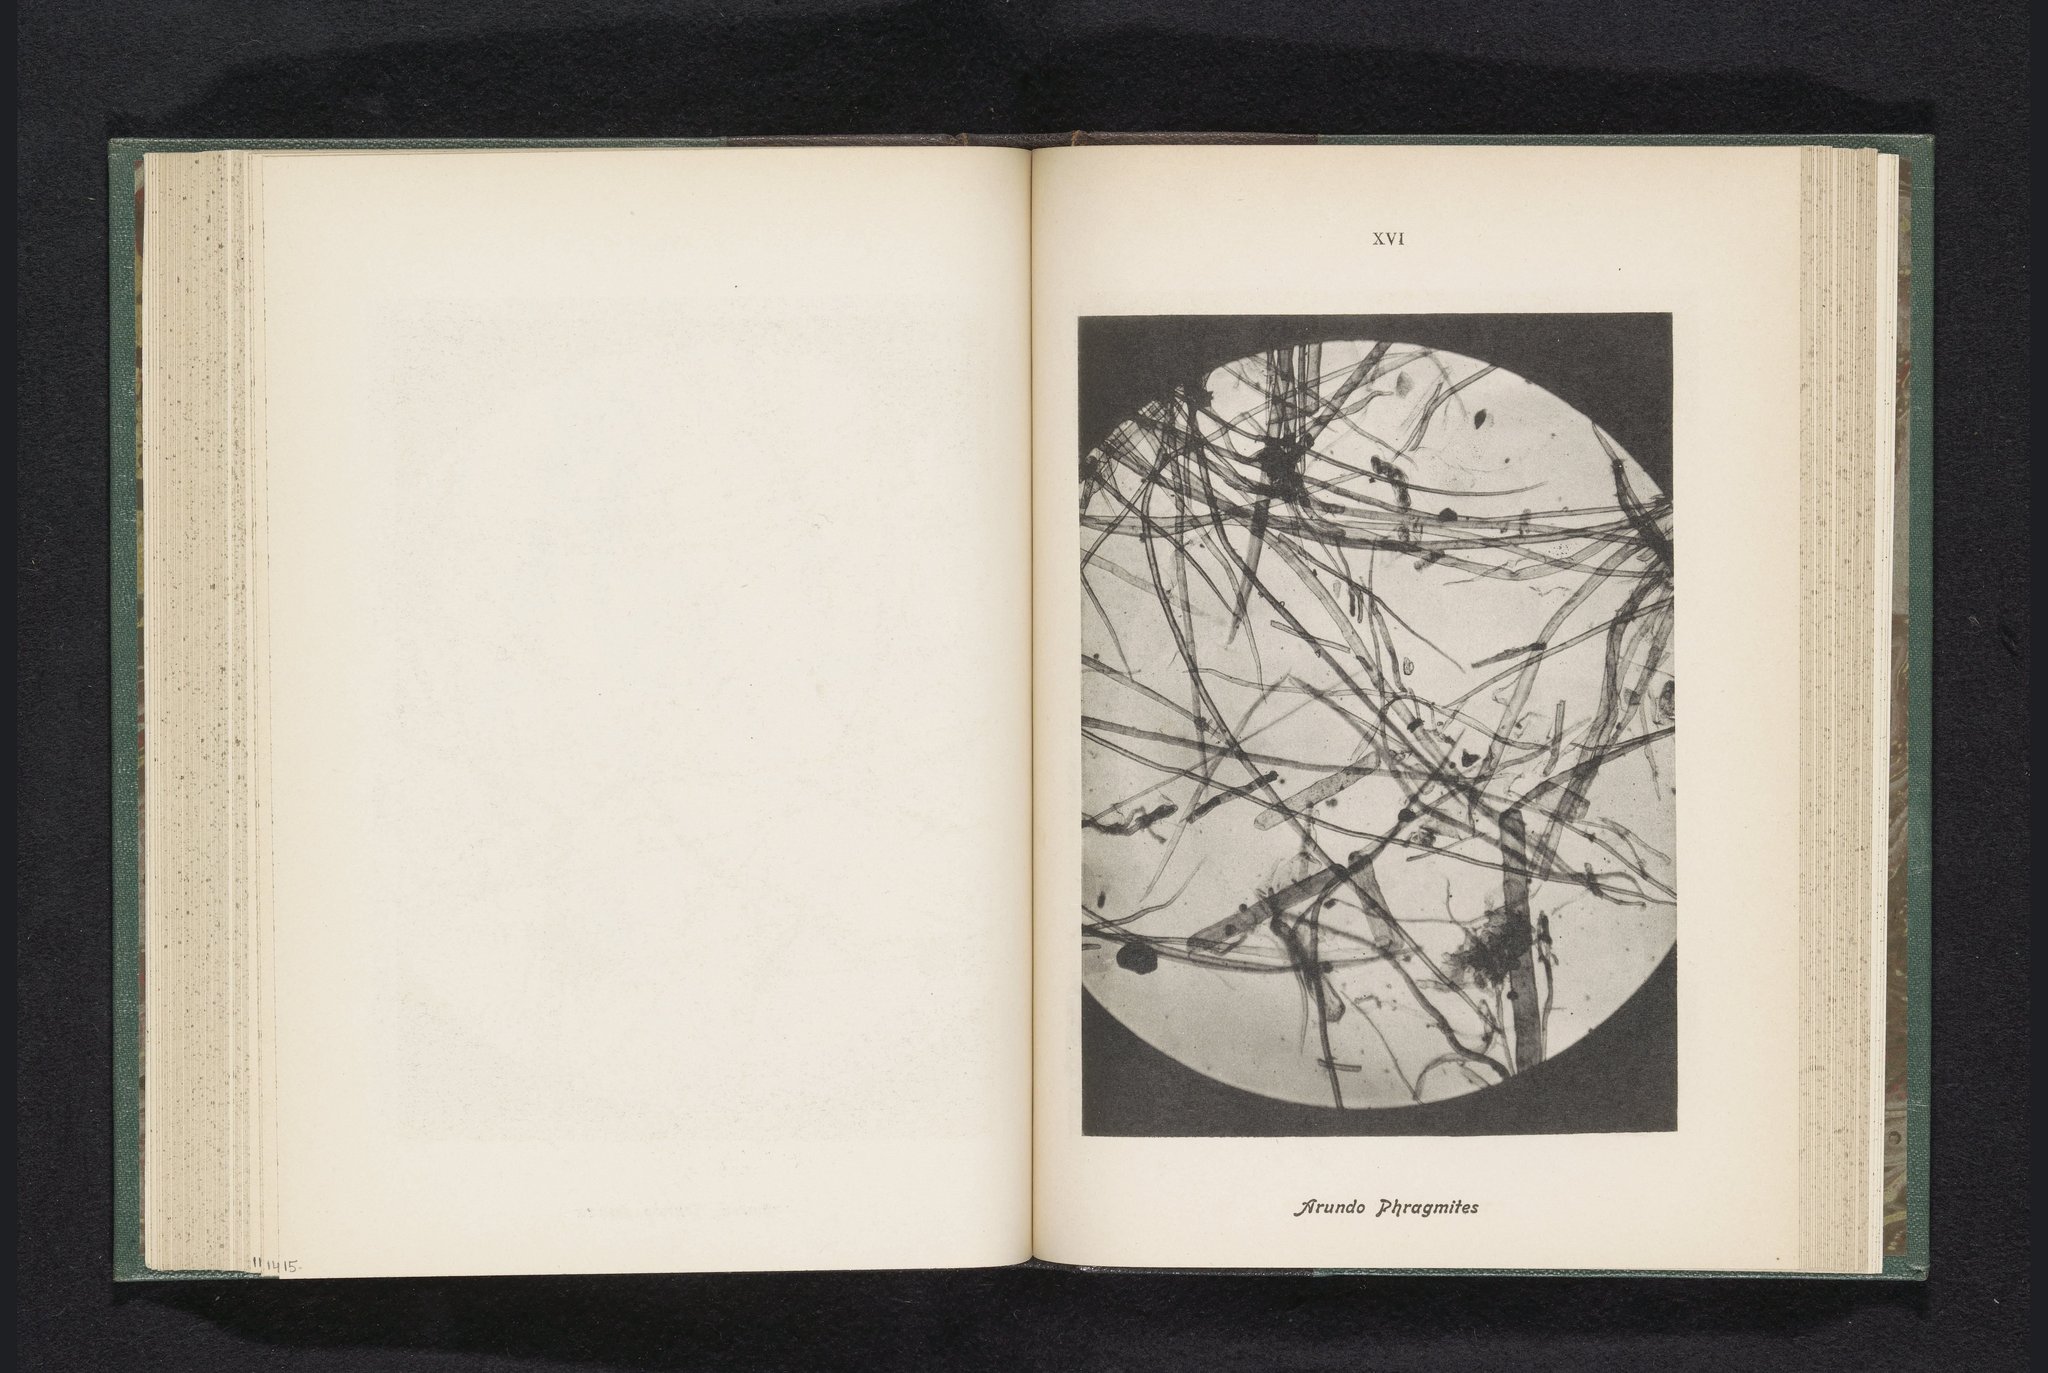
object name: photomechanical print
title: Micro-opname van de vezel van phragmites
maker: Anonymous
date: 1890-1900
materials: paper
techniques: photograph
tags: plants and herbs: reed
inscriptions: number: ‘XVI’